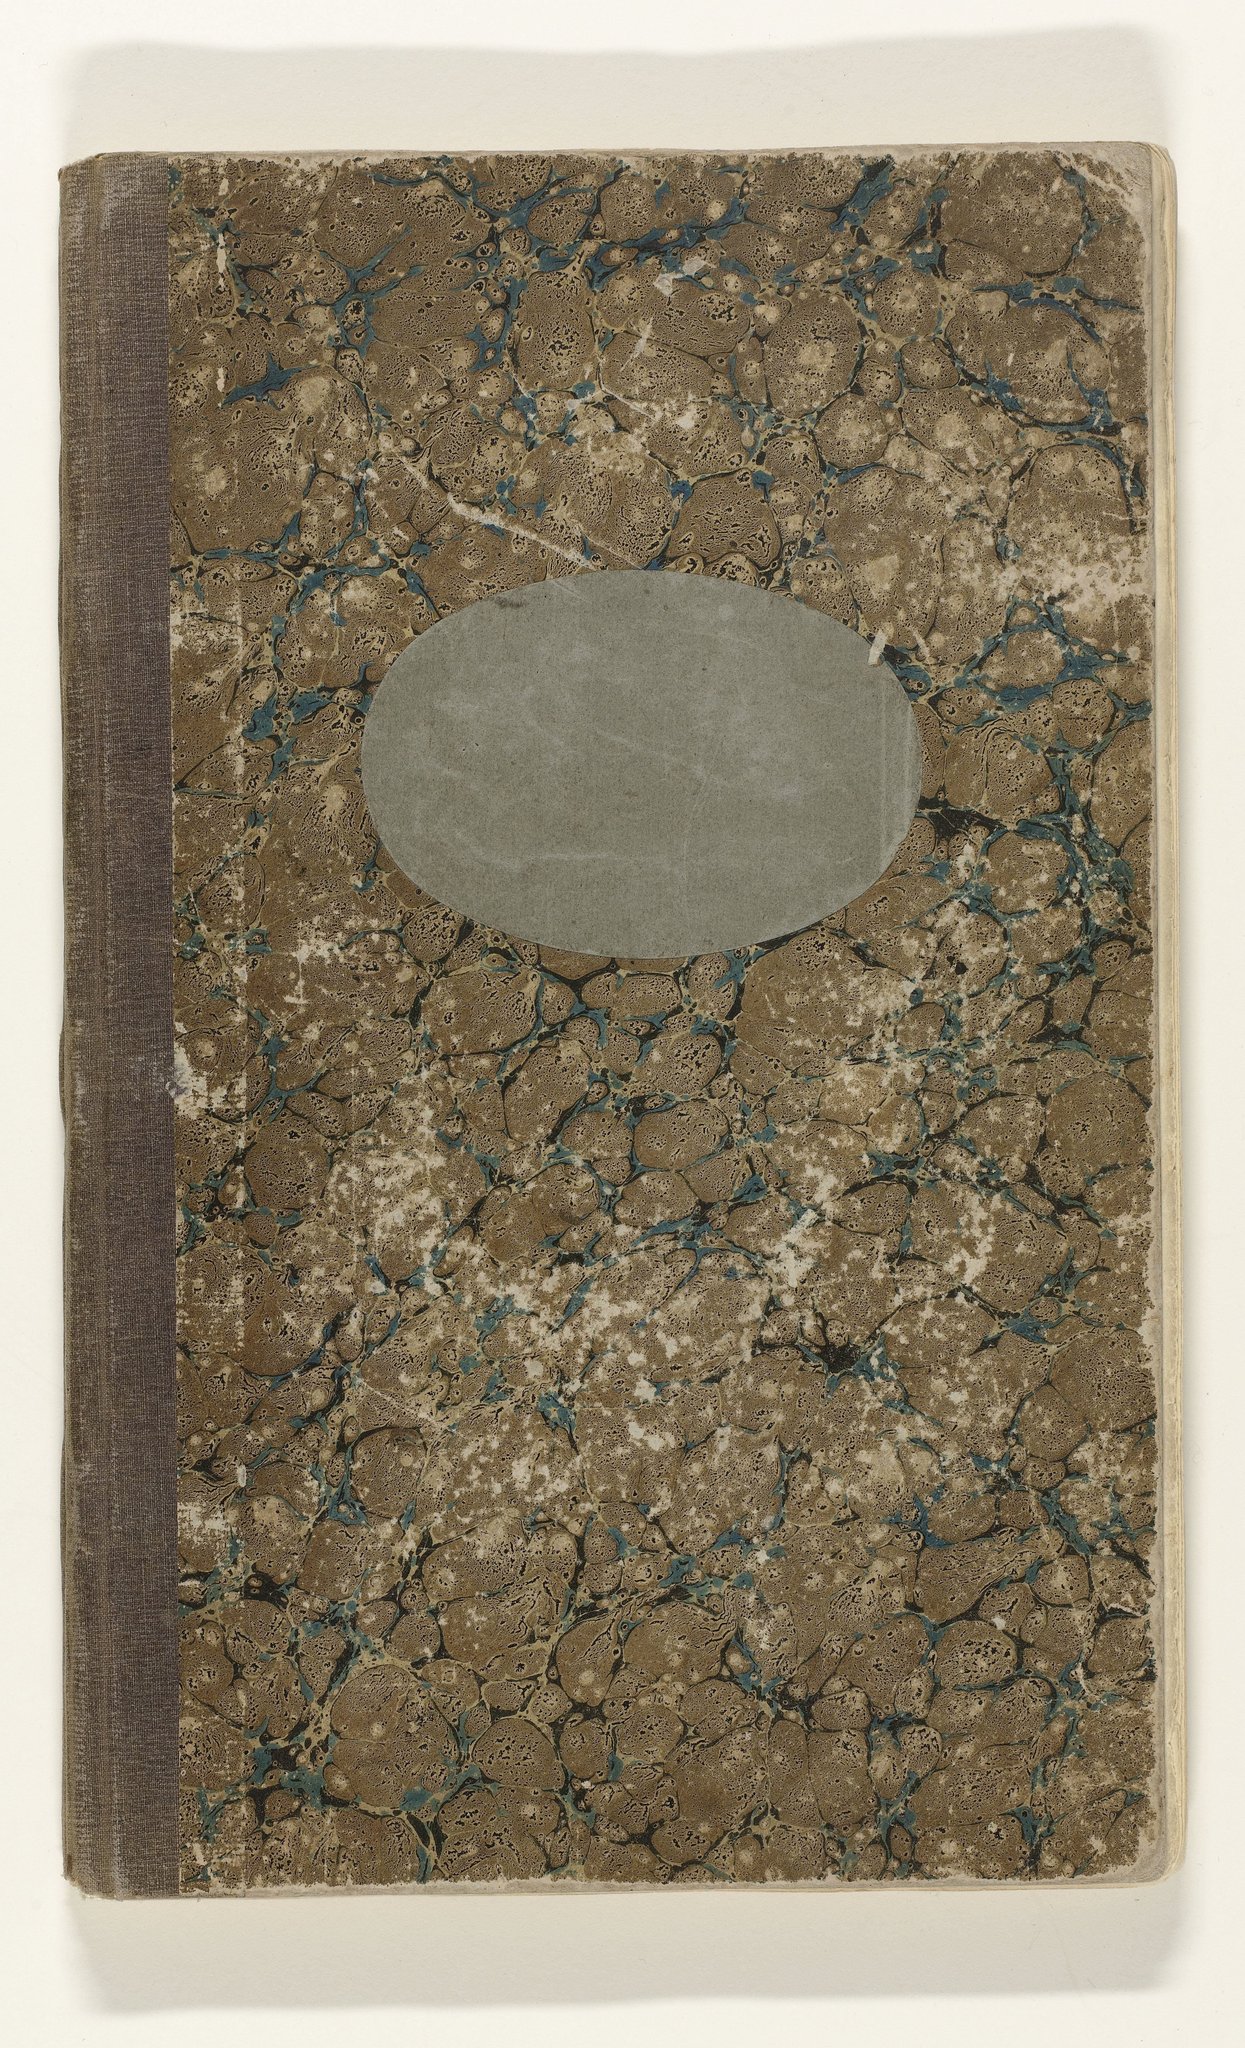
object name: photograph album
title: Fastes & Néfastes de la Photographie. Vie historique & philosophique d'un Photographe par lui même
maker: eduard isaac asser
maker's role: amateurfotograaf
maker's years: 1809-1894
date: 1845-1855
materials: cardboard, paper, photographic support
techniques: salted paper print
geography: amsterdam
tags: eduard isaac asser